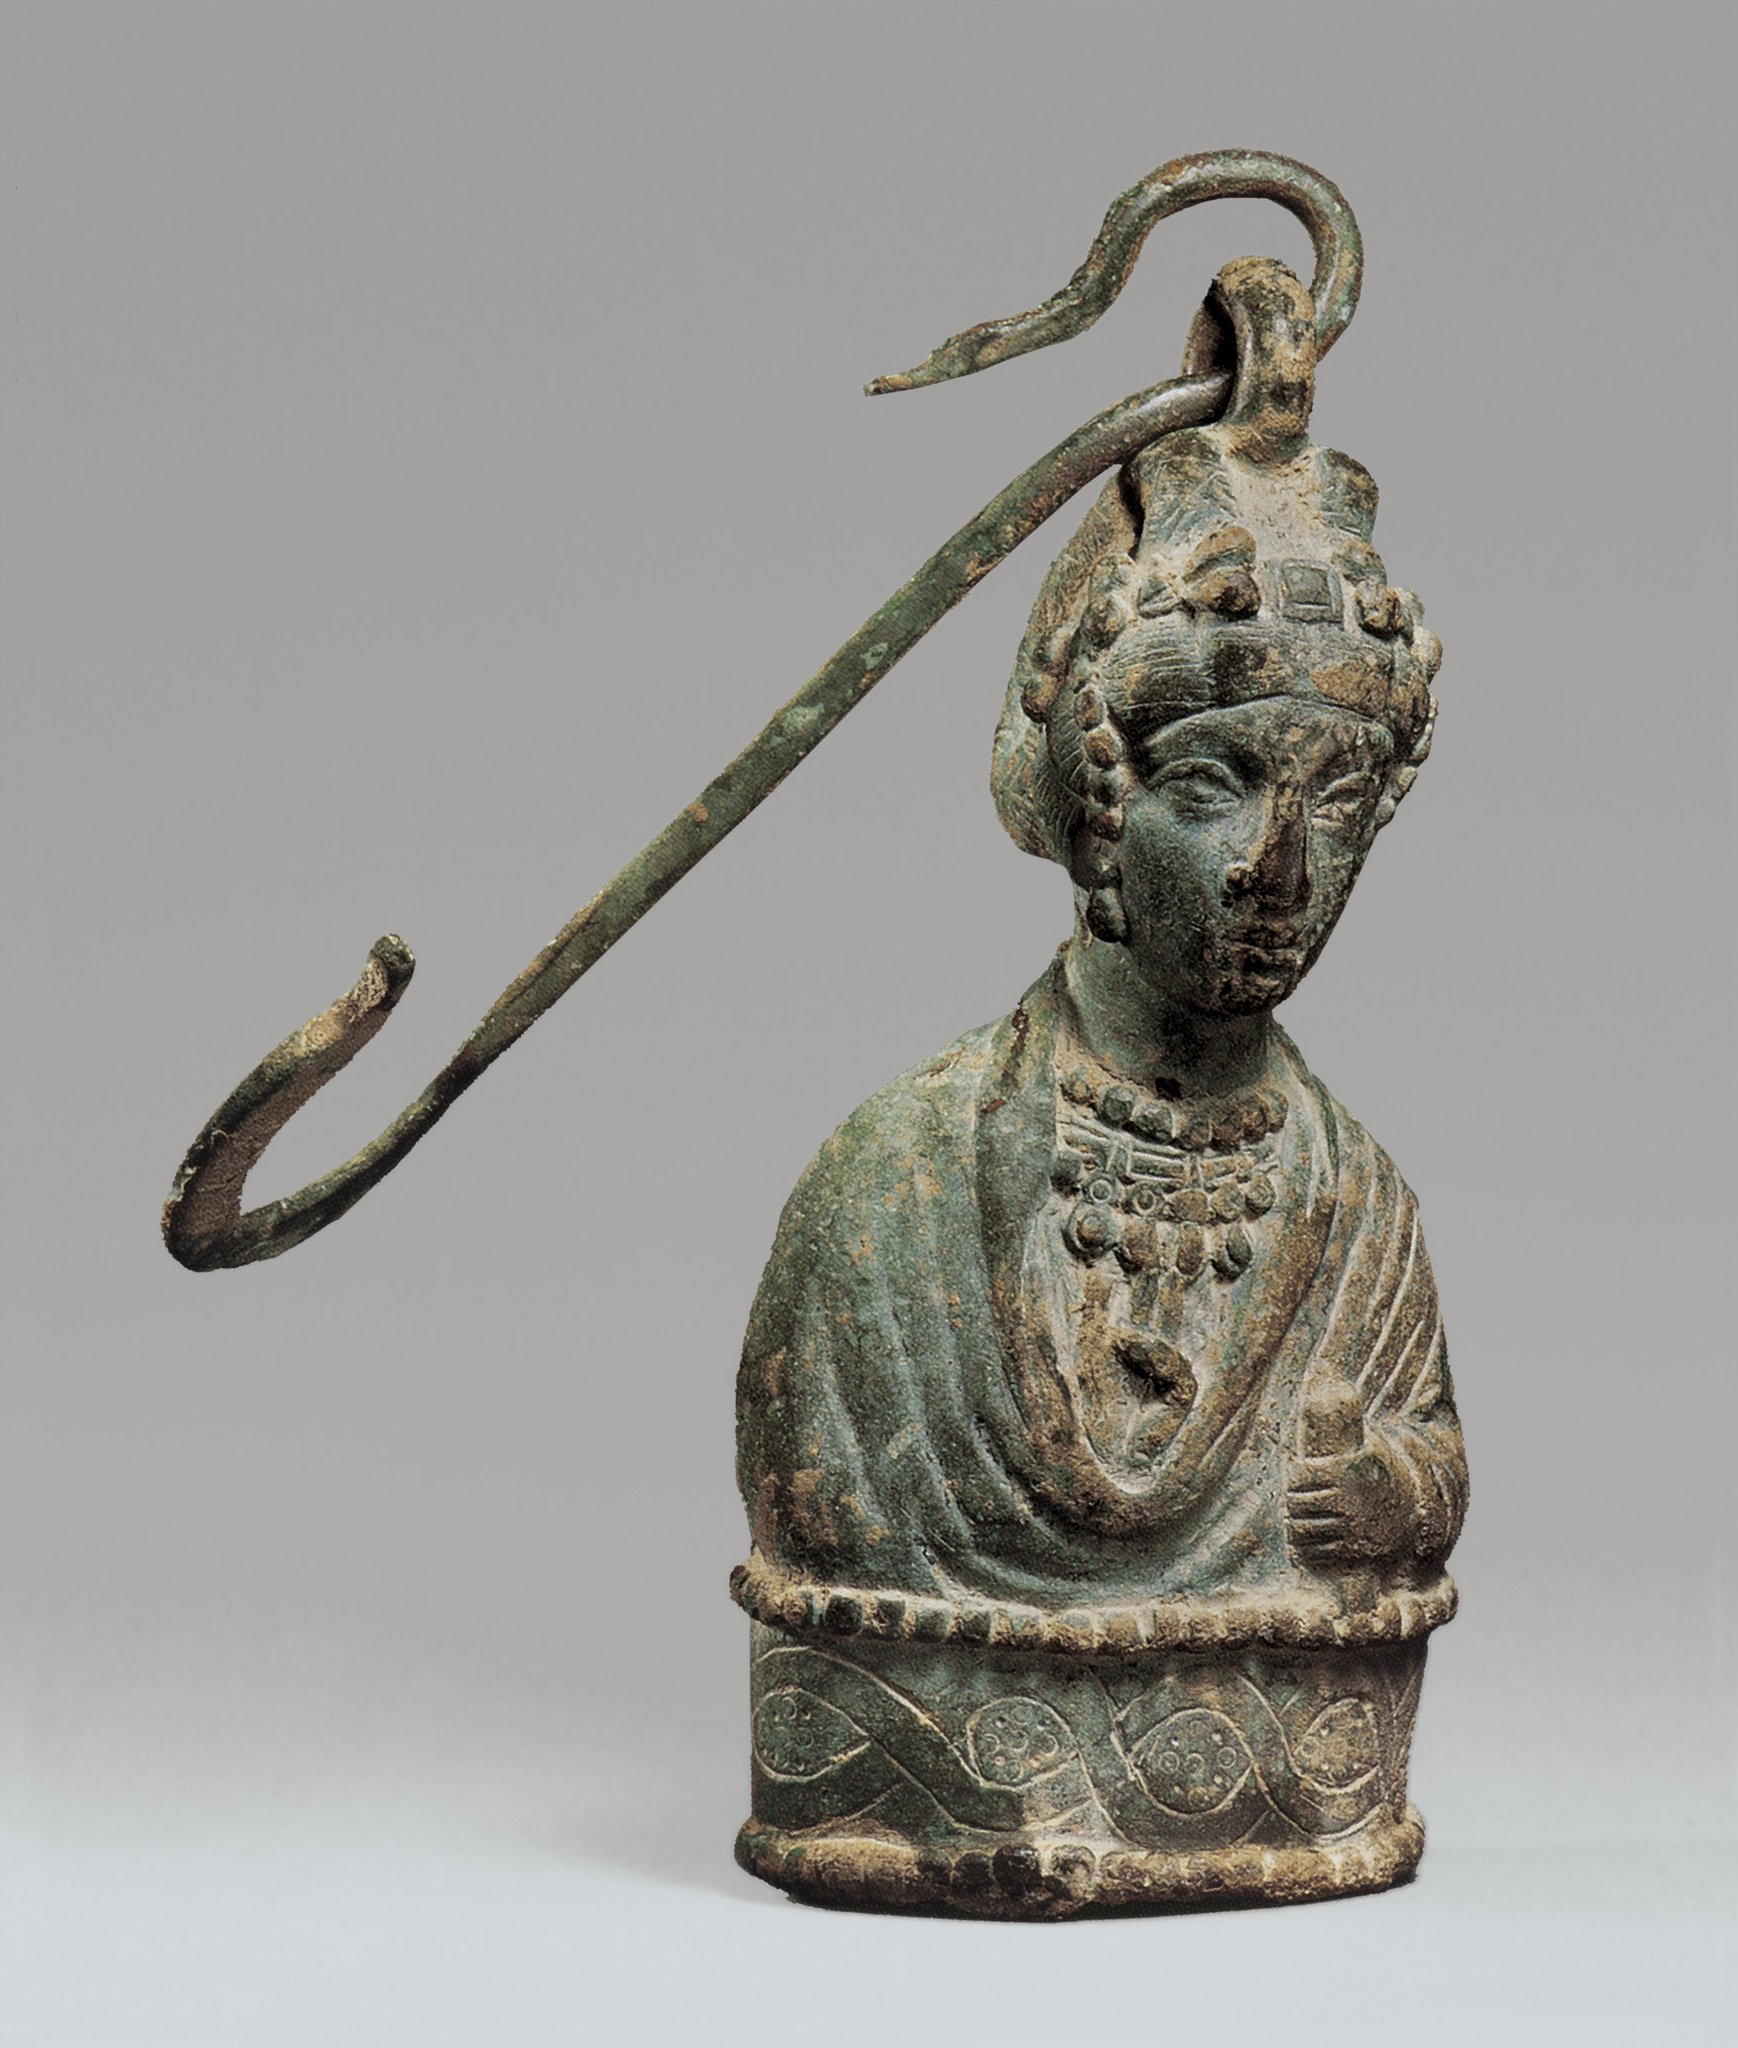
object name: steelyard weight and hook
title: Steelyard Weight with a Bust of a Byzantine Empress and a Hook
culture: byzantine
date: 400-450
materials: brass, copper alloy, lead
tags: women